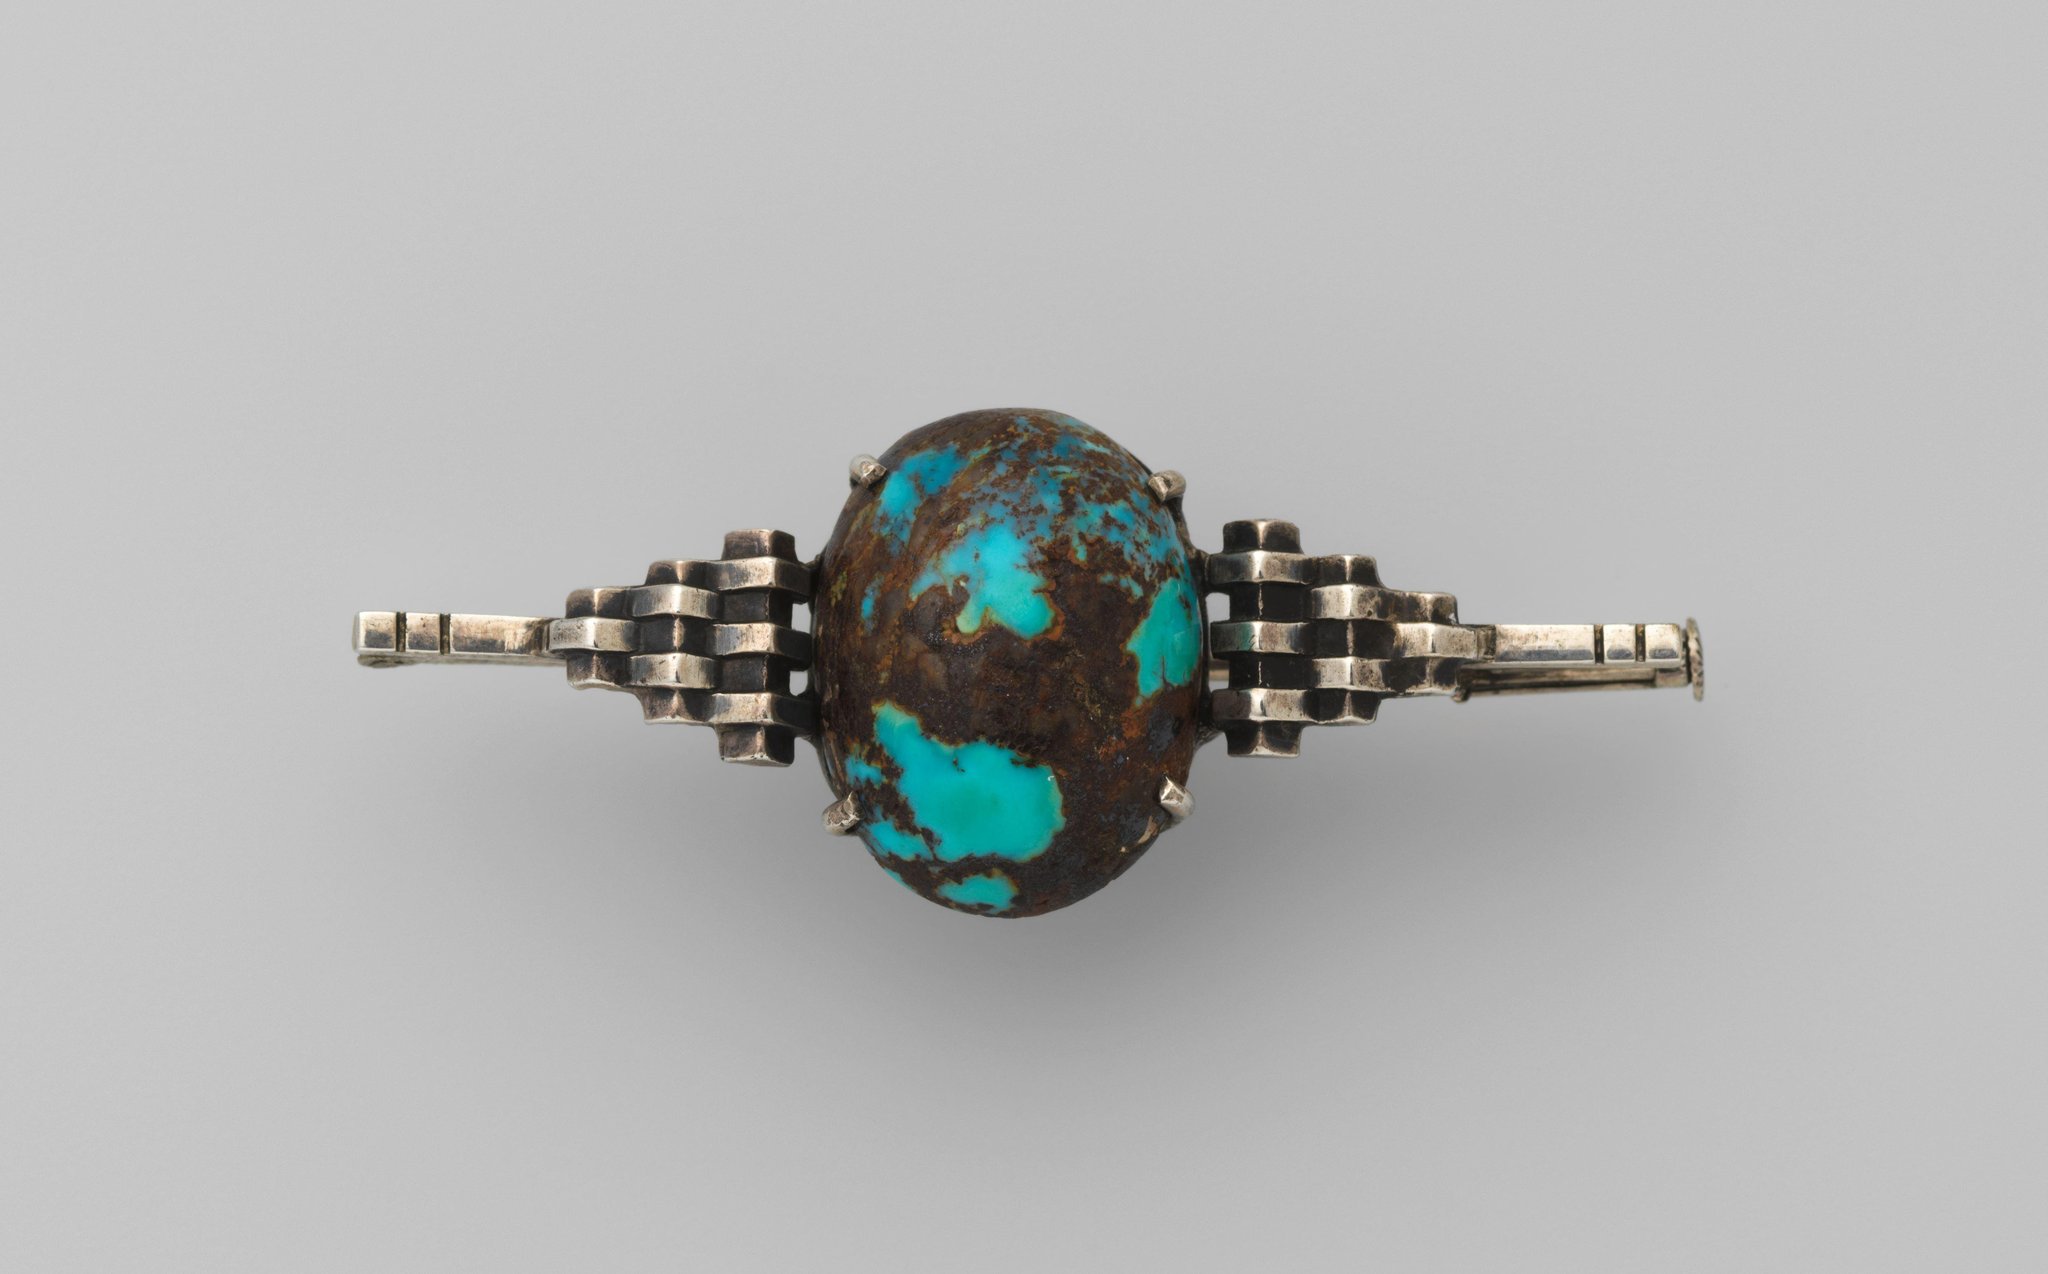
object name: brooch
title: Brochette van zilver en turkoois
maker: j.a.f. schutte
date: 1920-1940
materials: silver, gemstone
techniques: grinding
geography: netherlands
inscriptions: maker's mark: ‘JS3’, alloy mark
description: Brochette van zilver en ovaal cabochon geslepen turkoois met moedergesteente (matrix) voorzien van een kanonsluiting.